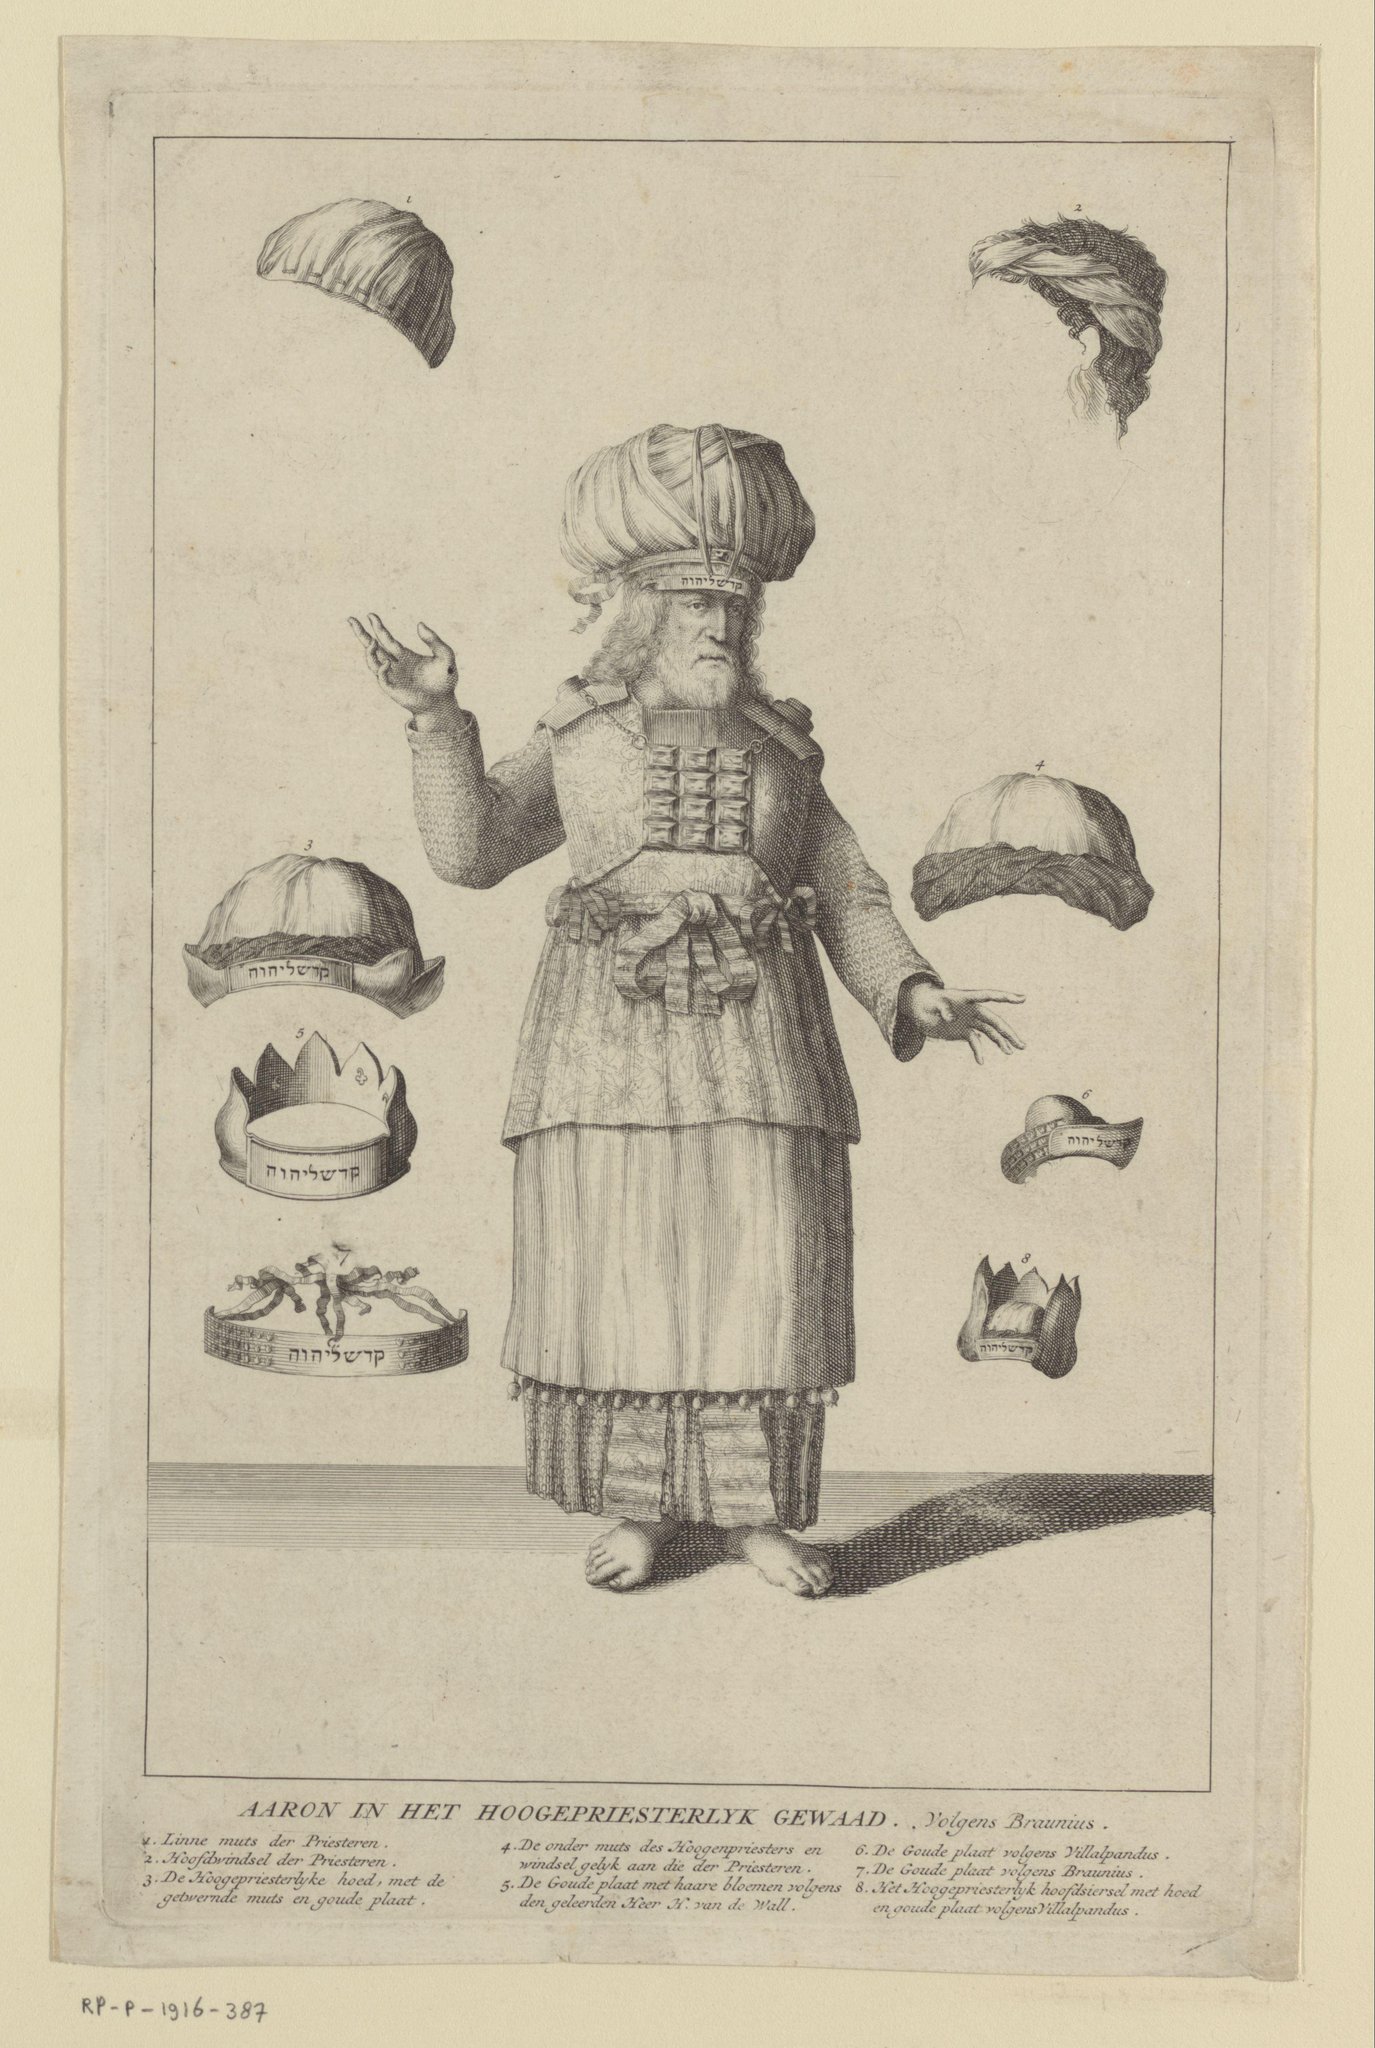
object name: book illustration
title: Aäron in het hoogepriesterlyk gewaad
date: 1725-1731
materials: paper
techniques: engraving, etching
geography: amsterdam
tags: vestments of high priest ~ jewish religion, head-gear, aaron (not in biblical context); possible attributes: attributes of aaron: censer, dressed as high priest or bishop, ointment jar, rod or flowering wand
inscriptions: collector's mark: Lugt 2228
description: Prent gebruikt voor: Calmet, Augustin. Het algemeen groot historisch, oordeelkundig, chronologisch, geografisch en letterlyk naam- en woord-boek van den gantschen H. Bybel. Amsterdam: R. en J. Wetstein en W. Smith, Leiden: S. Luchtmans, 1725-1731.